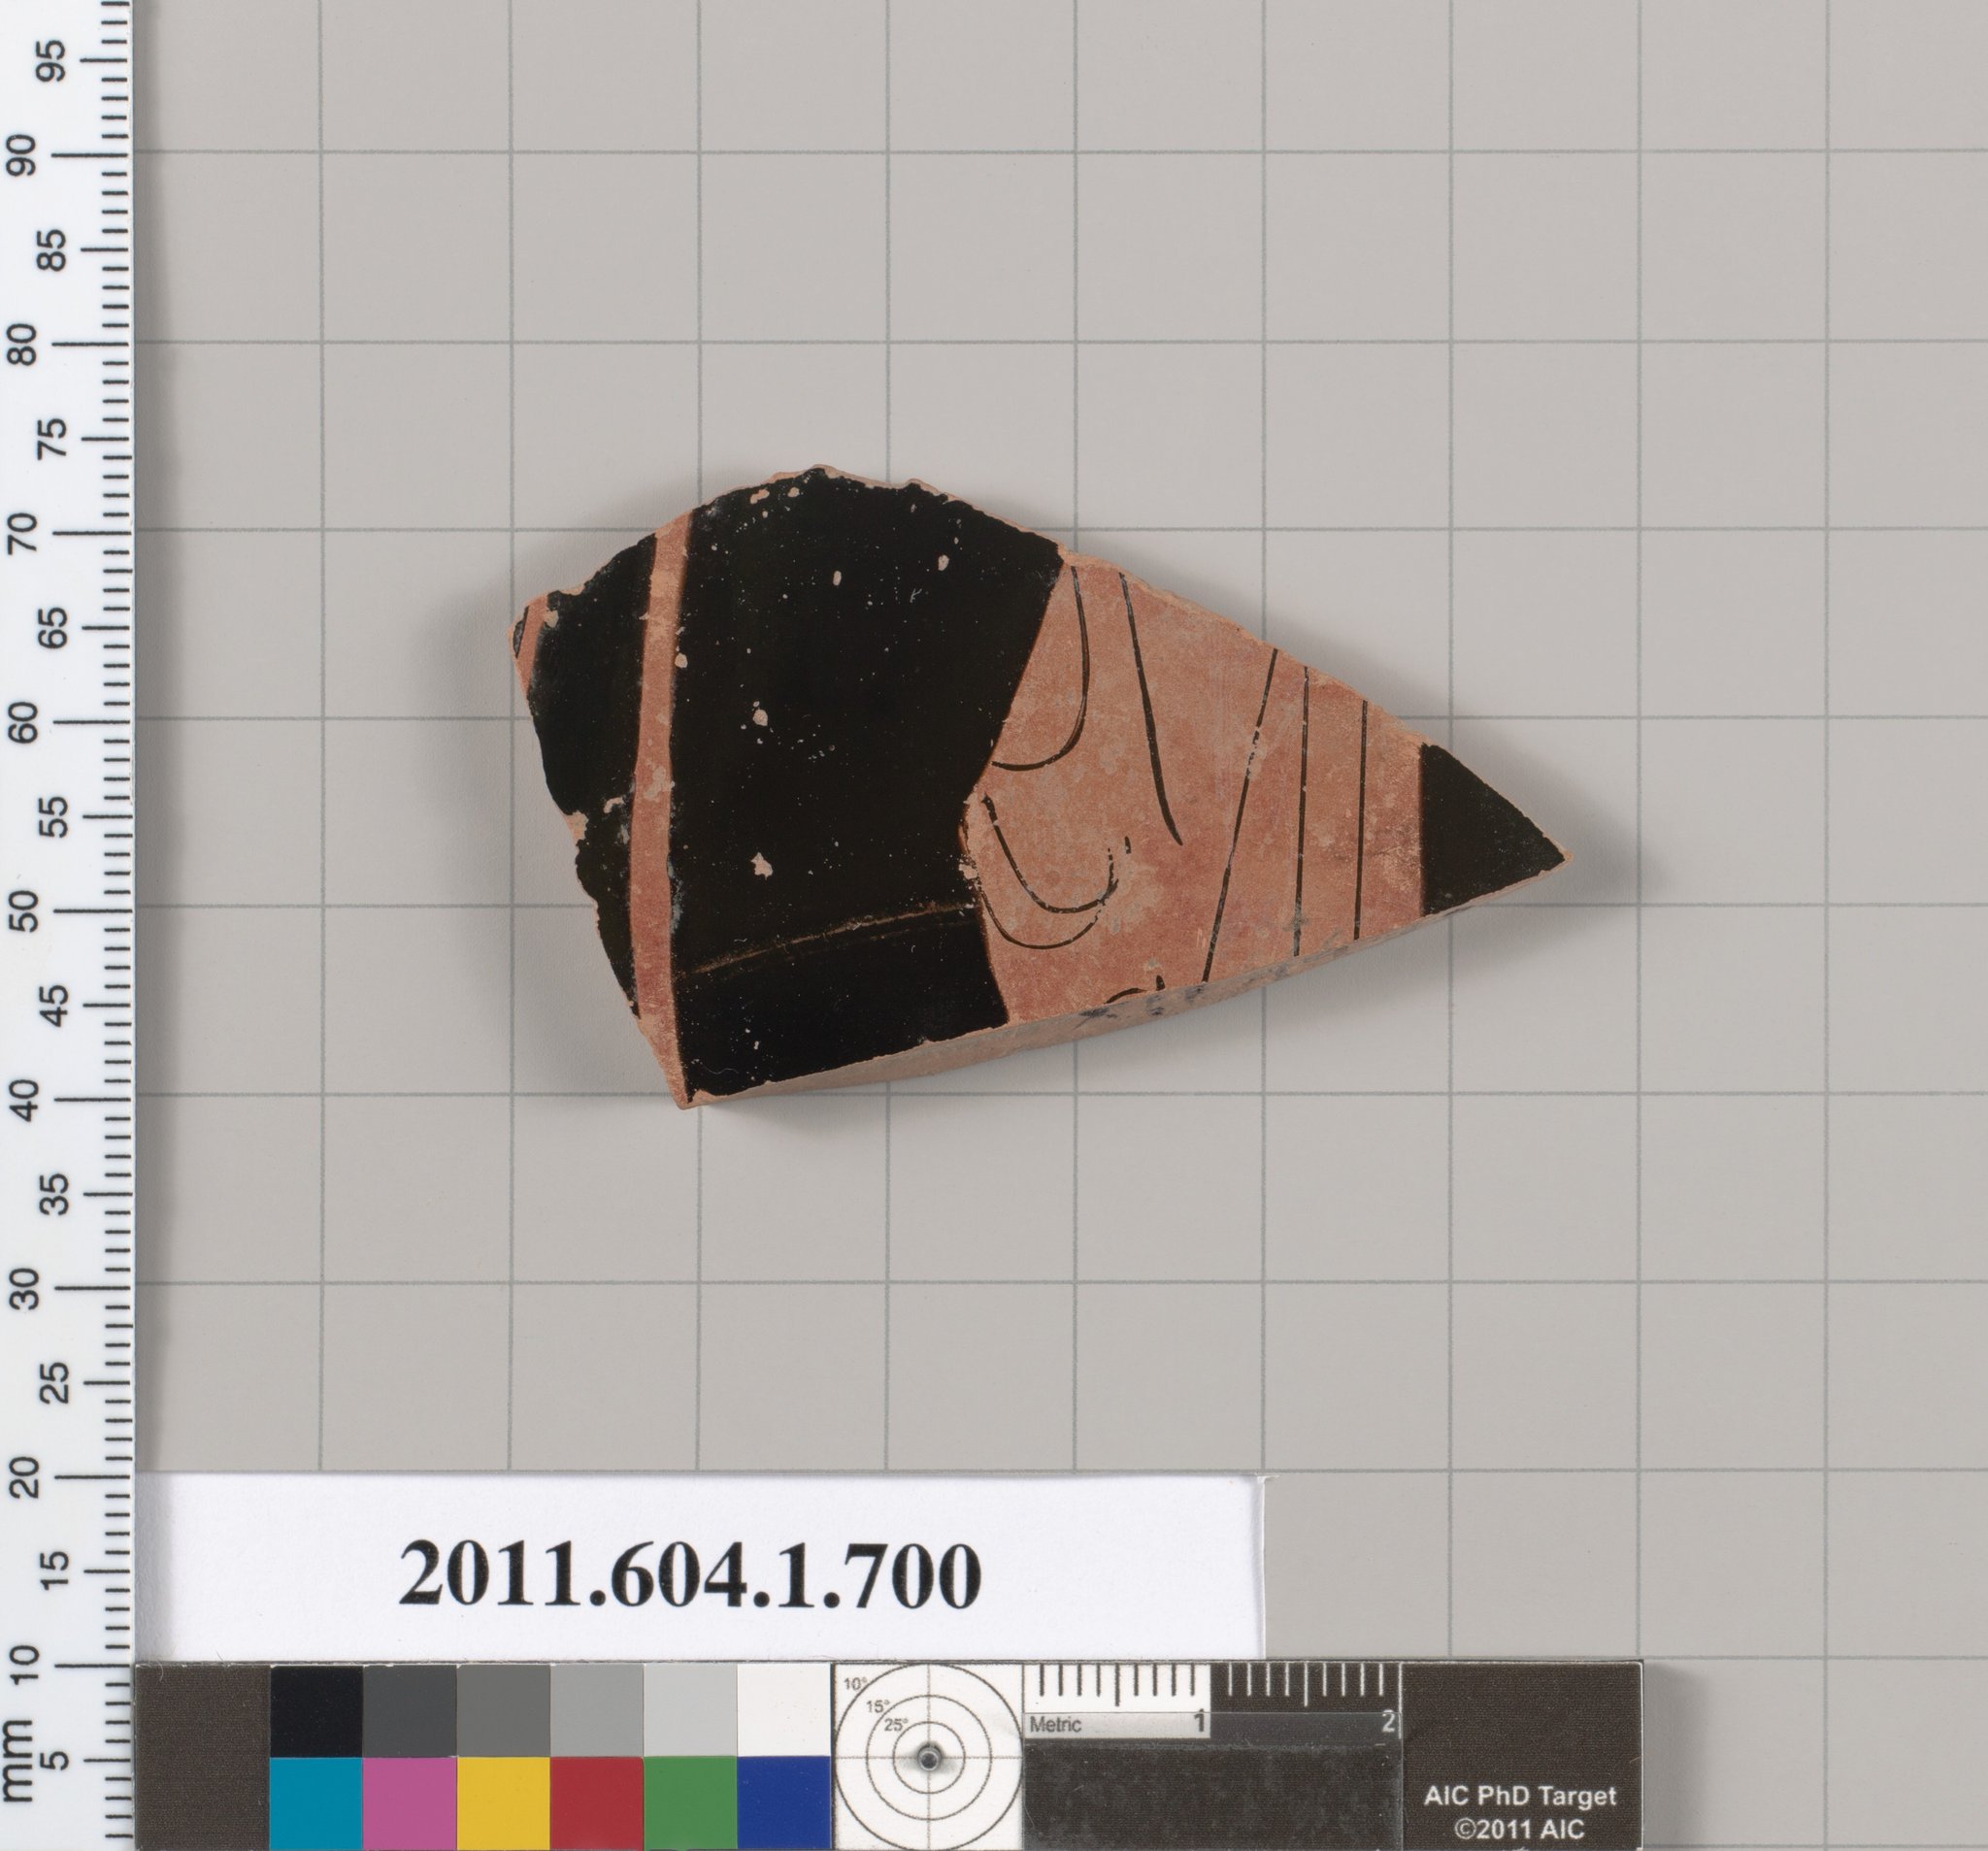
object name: kylix fragment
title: Terracotta fragment of a kylix (drinking cup)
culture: greek, attic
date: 475-451 BCE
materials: terracotta